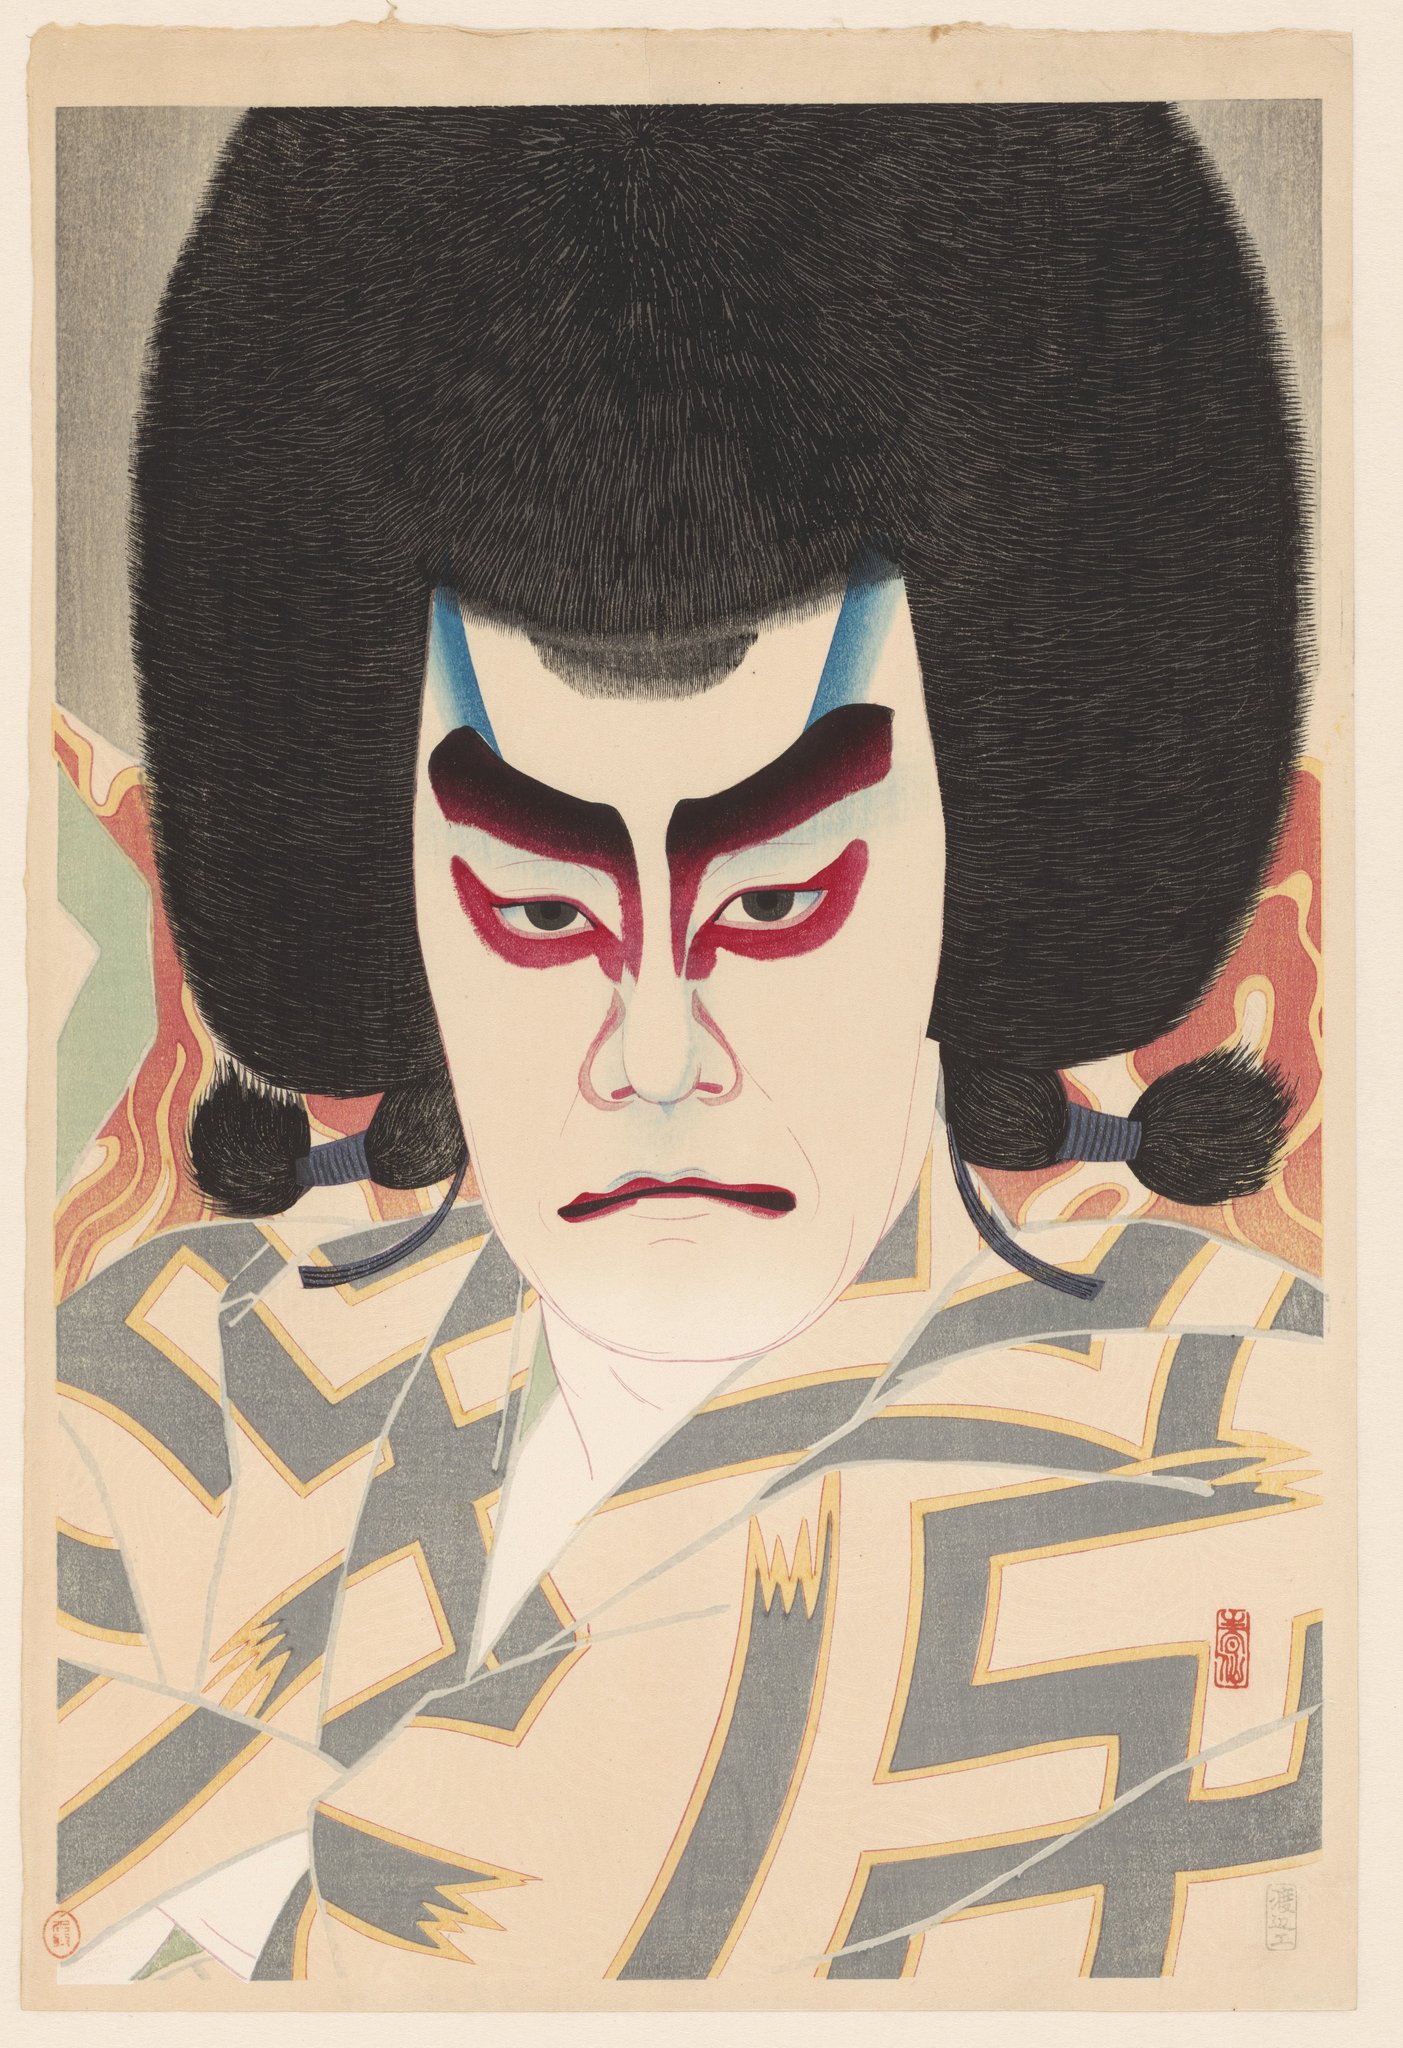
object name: print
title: Ichikawa Sadanji in de rol van Narukami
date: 1926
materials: paper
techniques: woodcut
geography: japan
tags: portrait of actor, actress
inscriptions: collector's mark: Lugt 2228, collector's mark: Lugt 2760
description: Portret van de acteur Ichikawa Sadanji in de rol van Narukami, met wit geschminkt gezicht, rode en blauwe accenten, zwart hoog kapsel met twee staartjes.